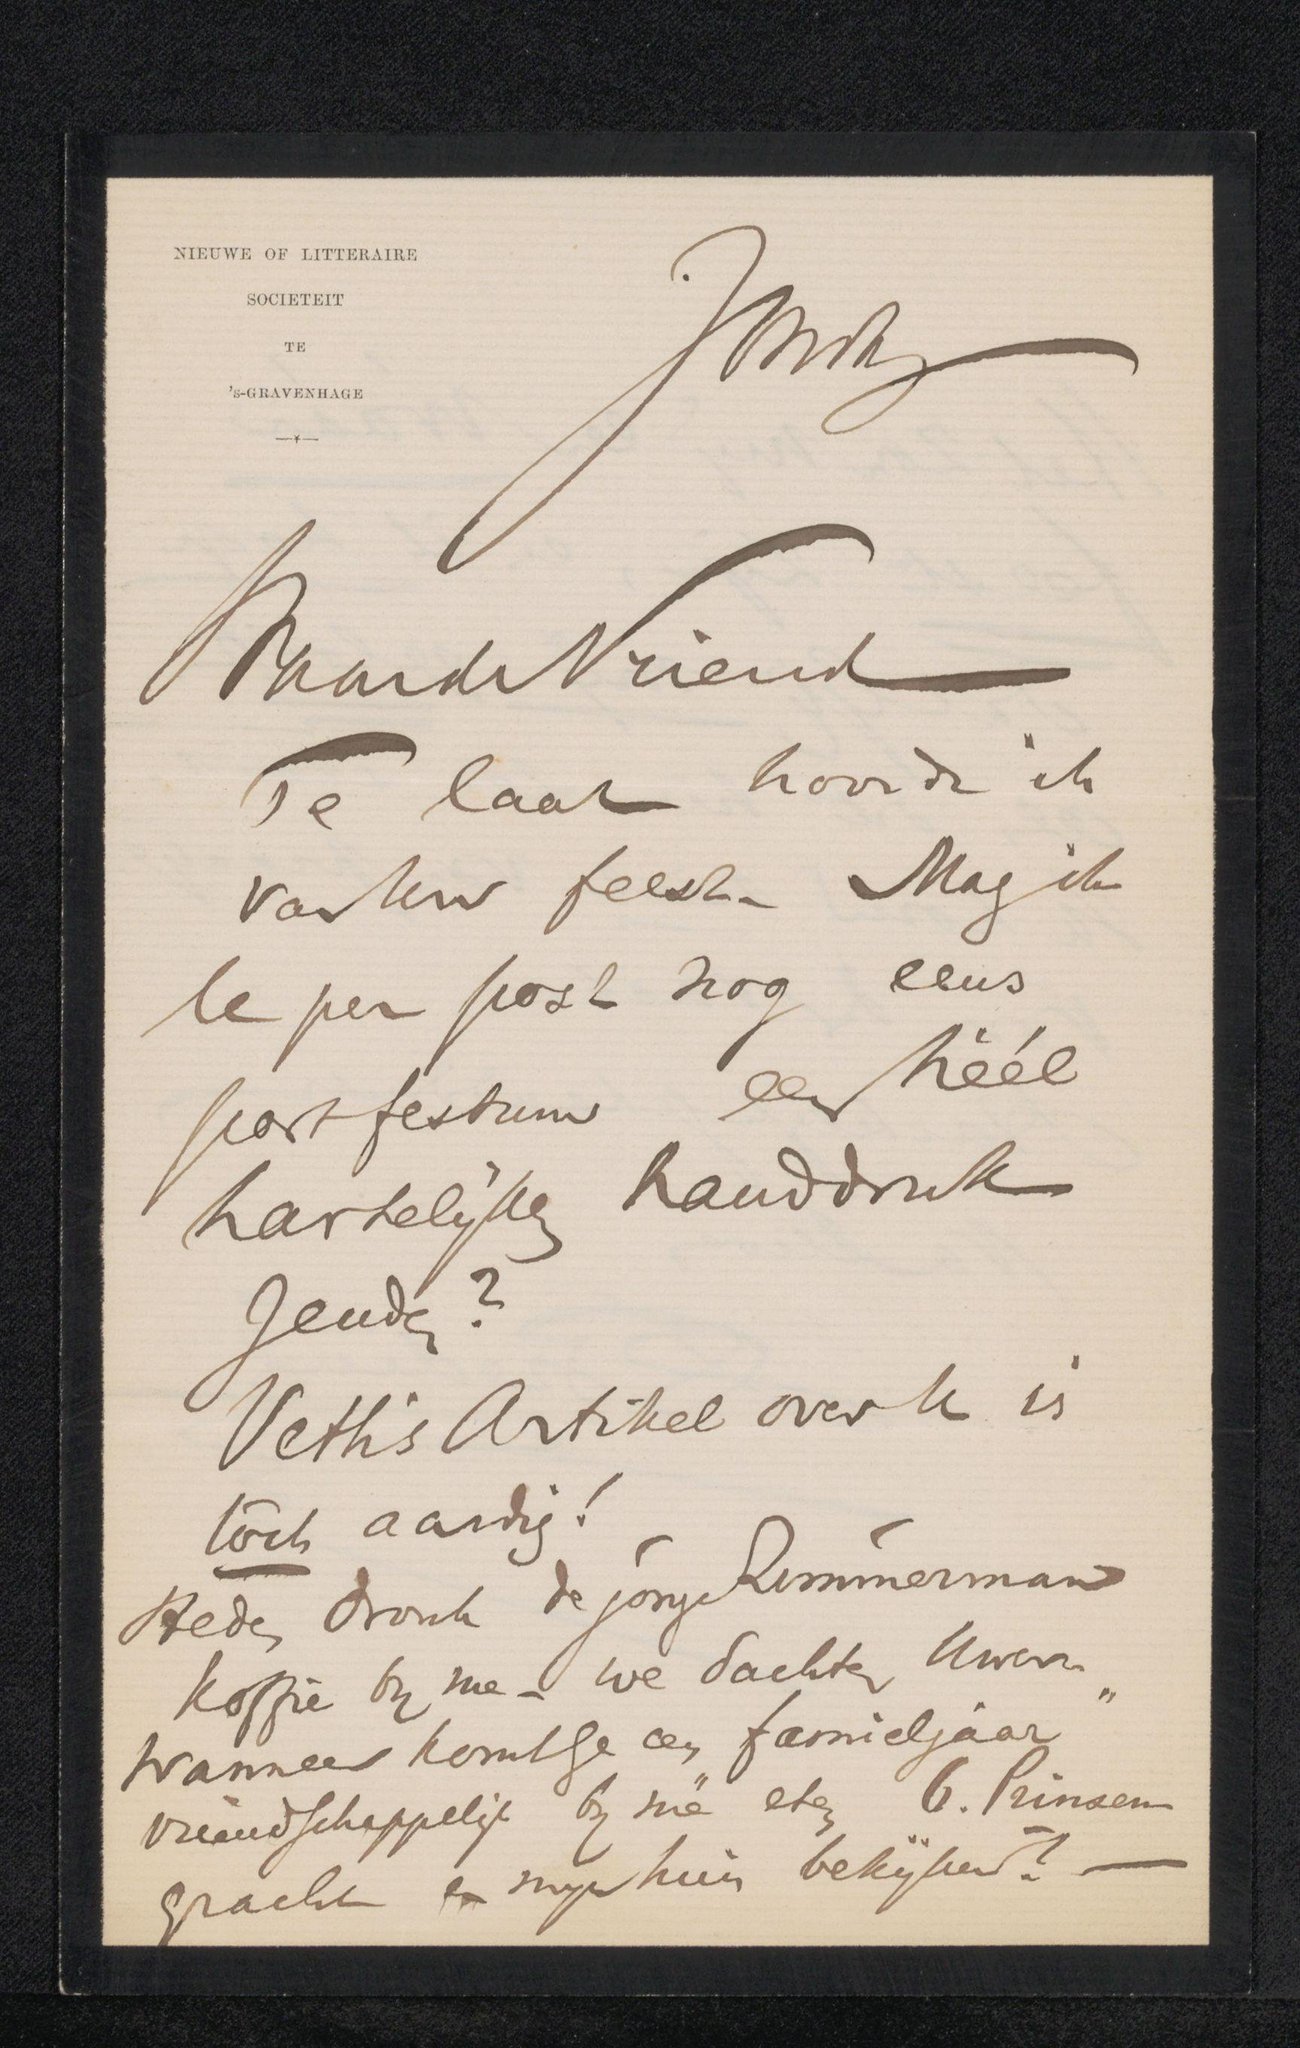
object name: letter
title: Brief aan August Allebé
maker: abraham bredius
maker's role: kunsthistoricus, museumdirecteur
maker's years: 1855-1946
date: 1865-1927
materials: ink, paper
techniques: pen, printing, writing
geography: the hague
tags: august allebé, painter, print maker, draughtsman, jan veth